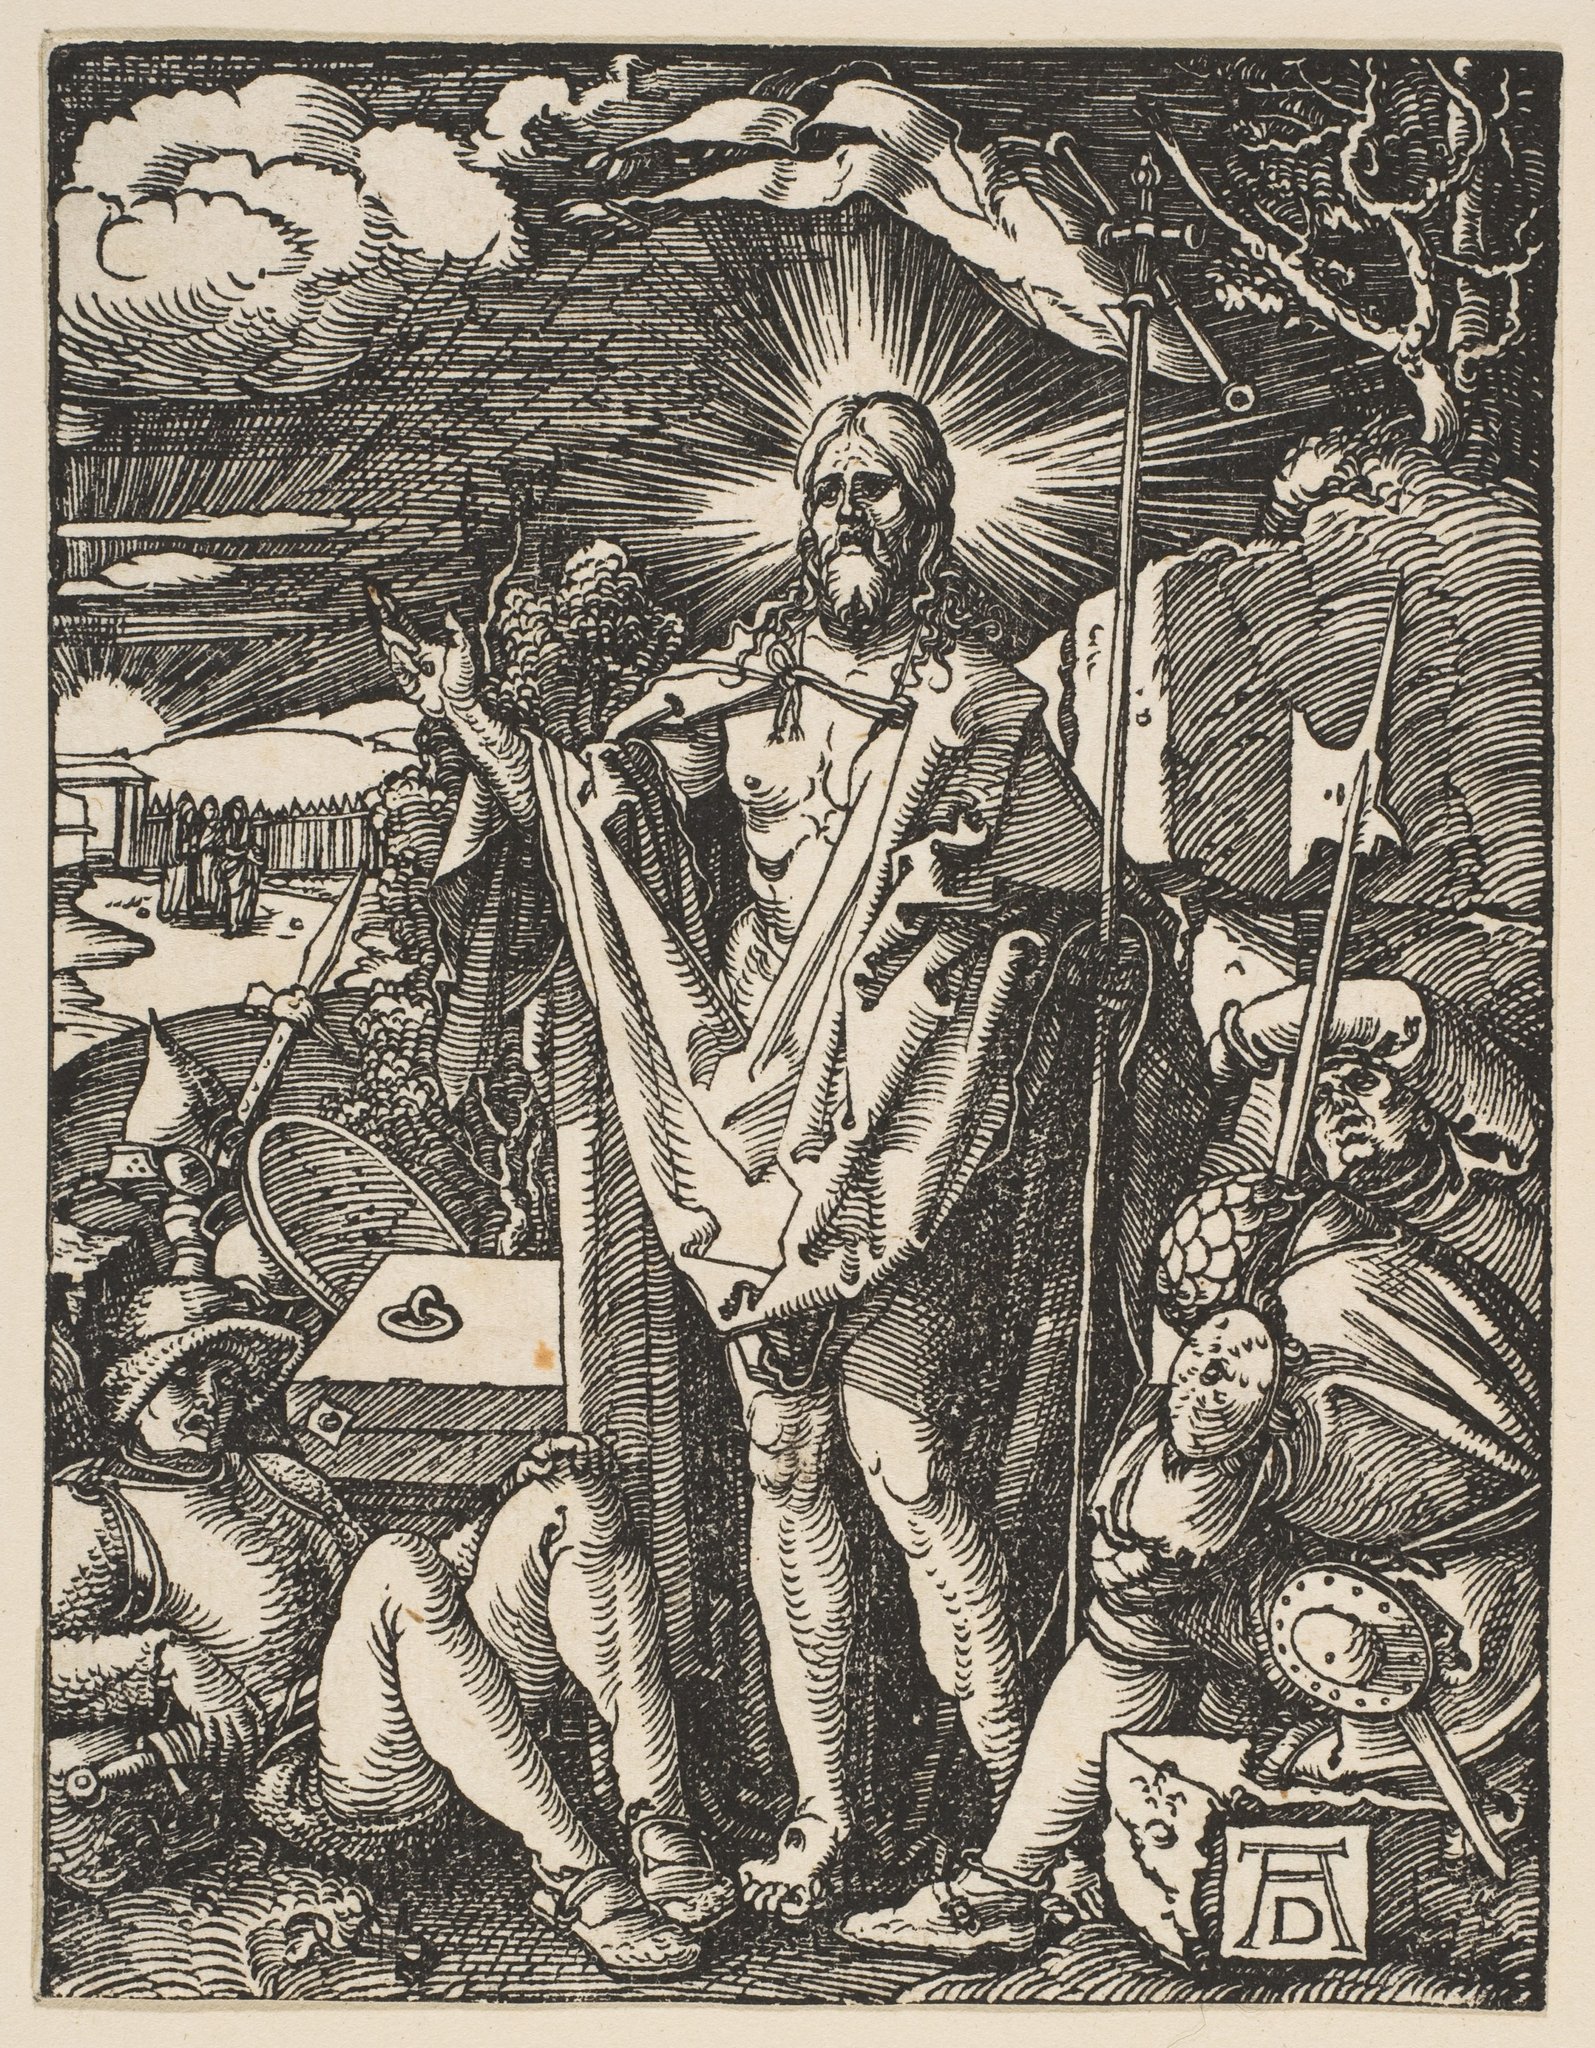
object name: print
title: The Resurrection, from "The Little Passion"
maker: albrecht dürer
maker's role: artist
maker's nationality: german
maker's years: 1471-1528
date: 1510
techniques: woodcut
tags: weapons,men,jesus